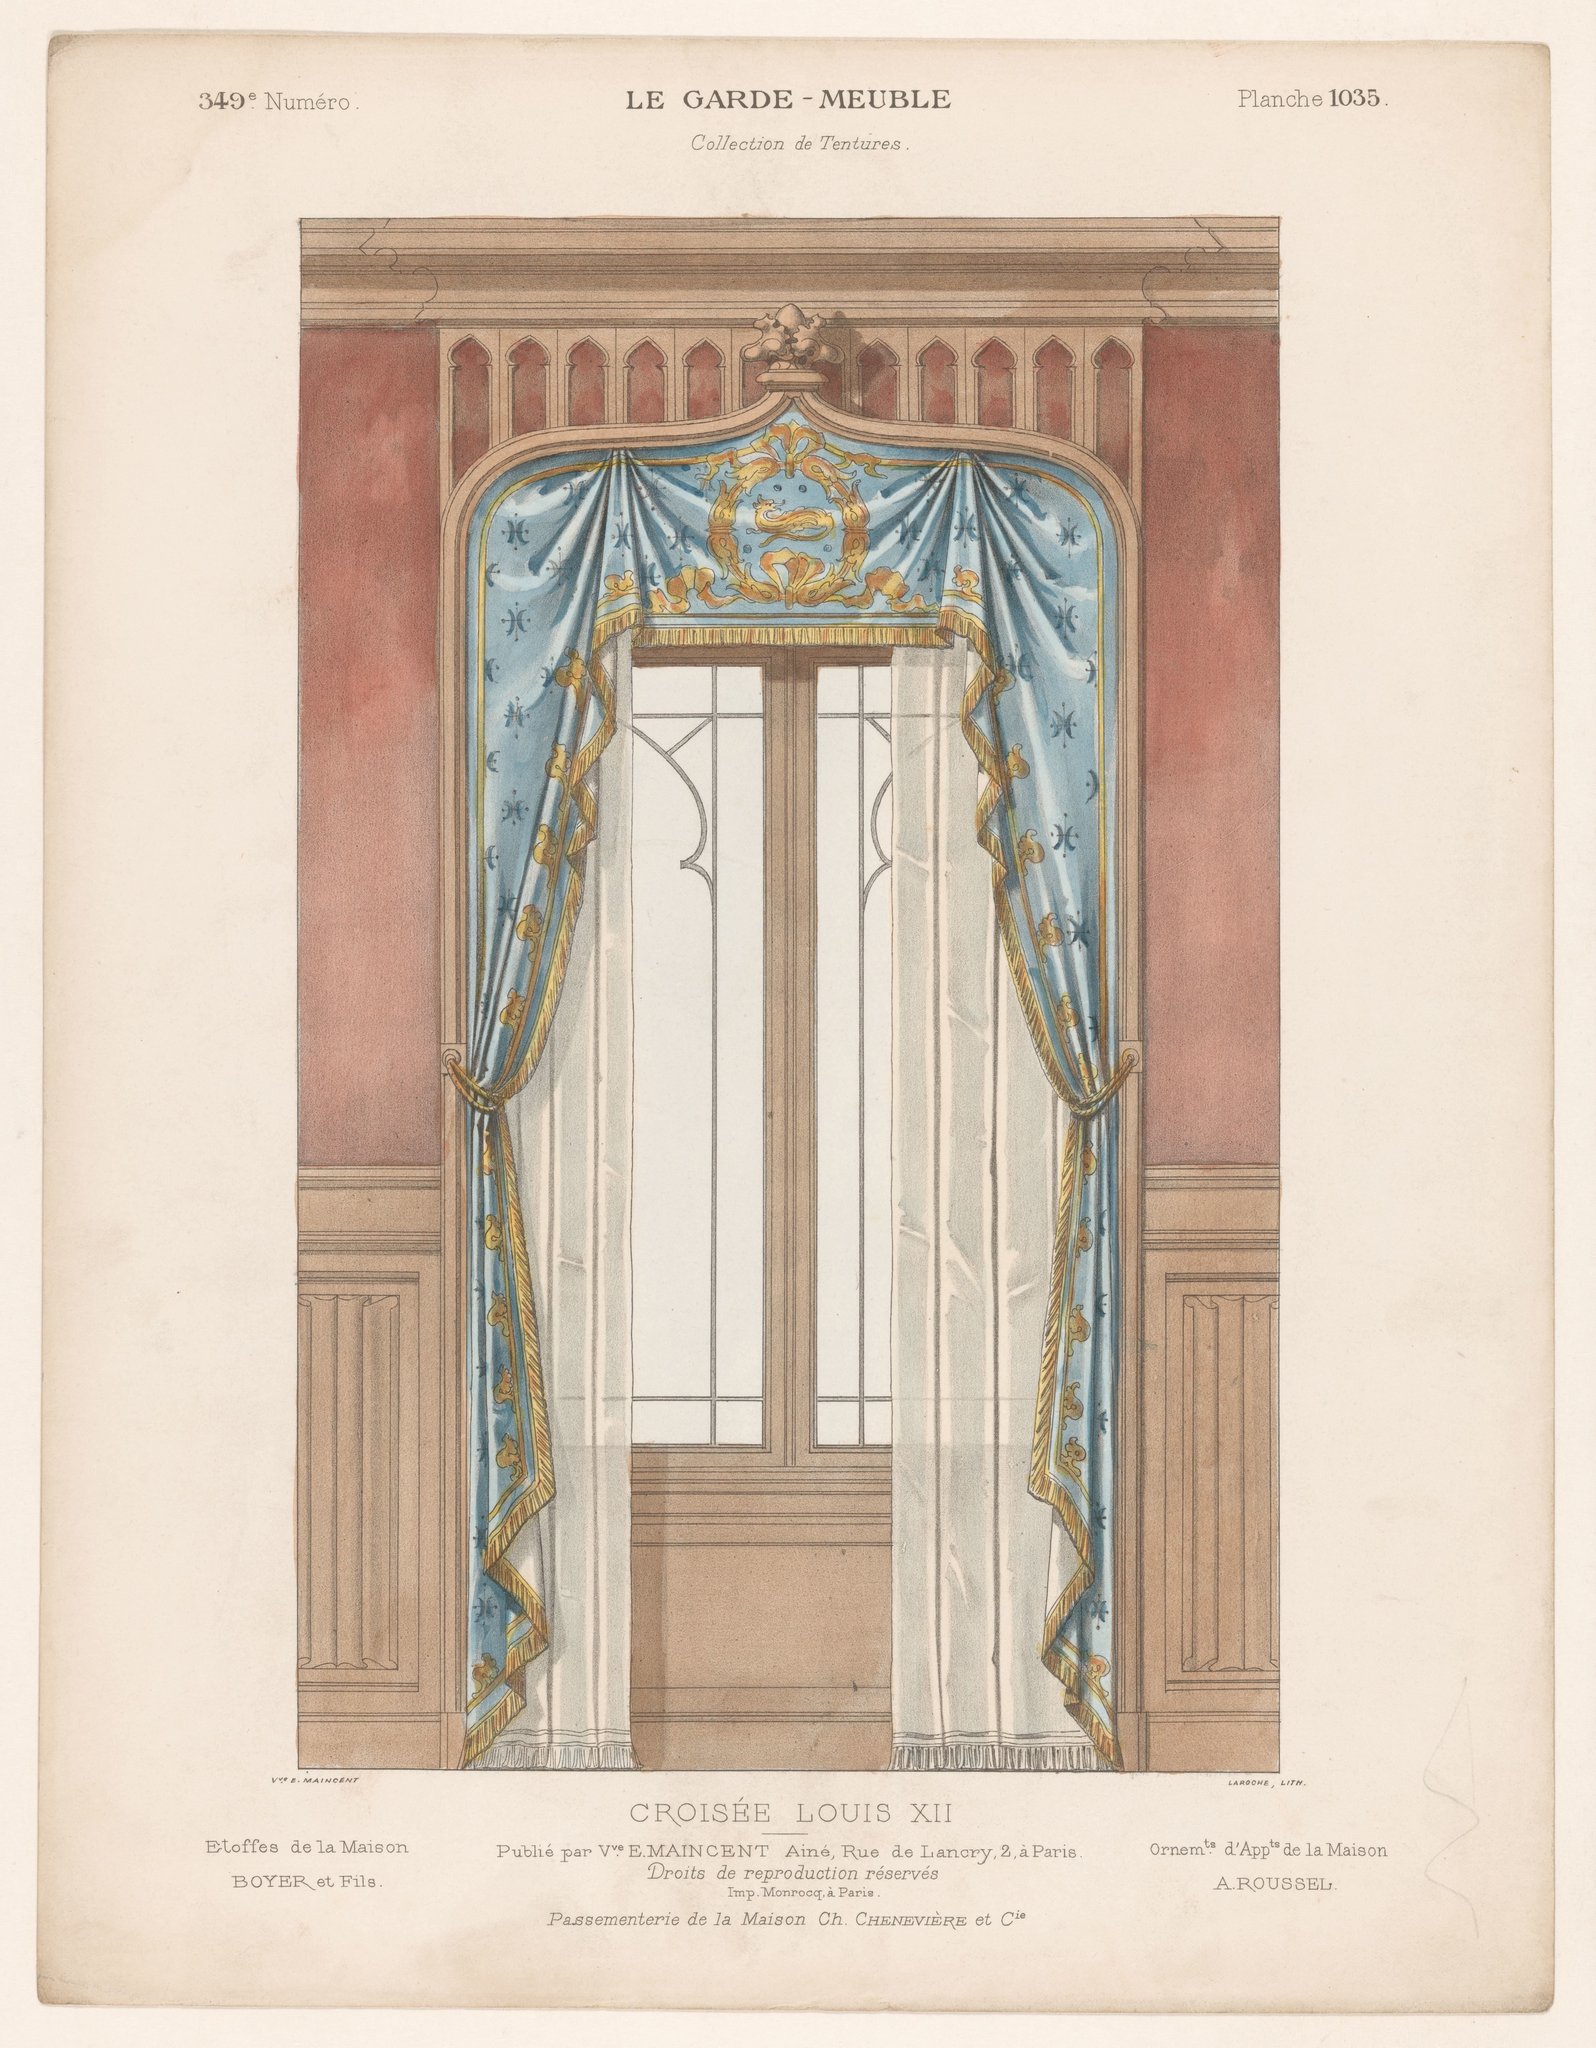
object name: print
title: Venster met gordijnen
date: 1895-1910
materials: paper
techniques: hand coloring, lithograph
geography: paris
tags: window, hangings and drapery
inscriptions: : ‘Droits de reproduction réservés.’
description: Kruisvenster met gedrapeerde gordijnen in de Lodewijk XII-stijl. Prent uit 349e Livraison.